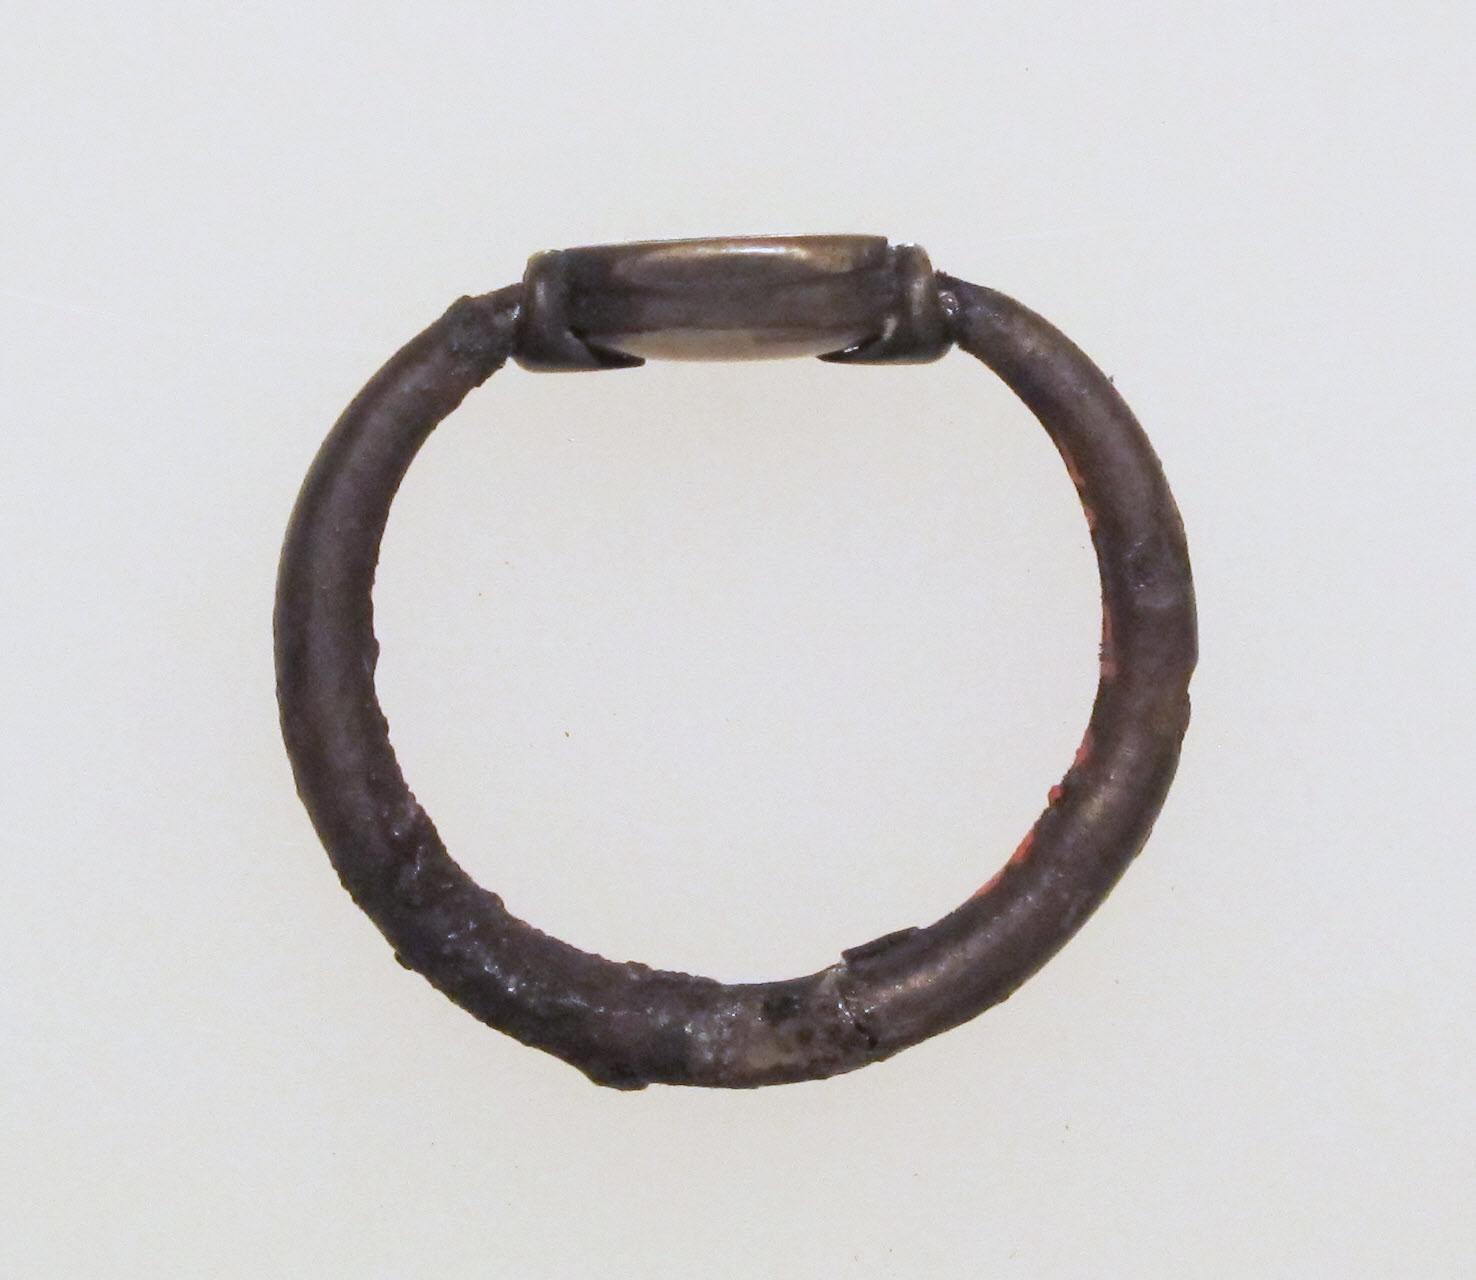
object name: ring with scaraboid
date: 7000 BCE-330 CE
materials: stone, silver